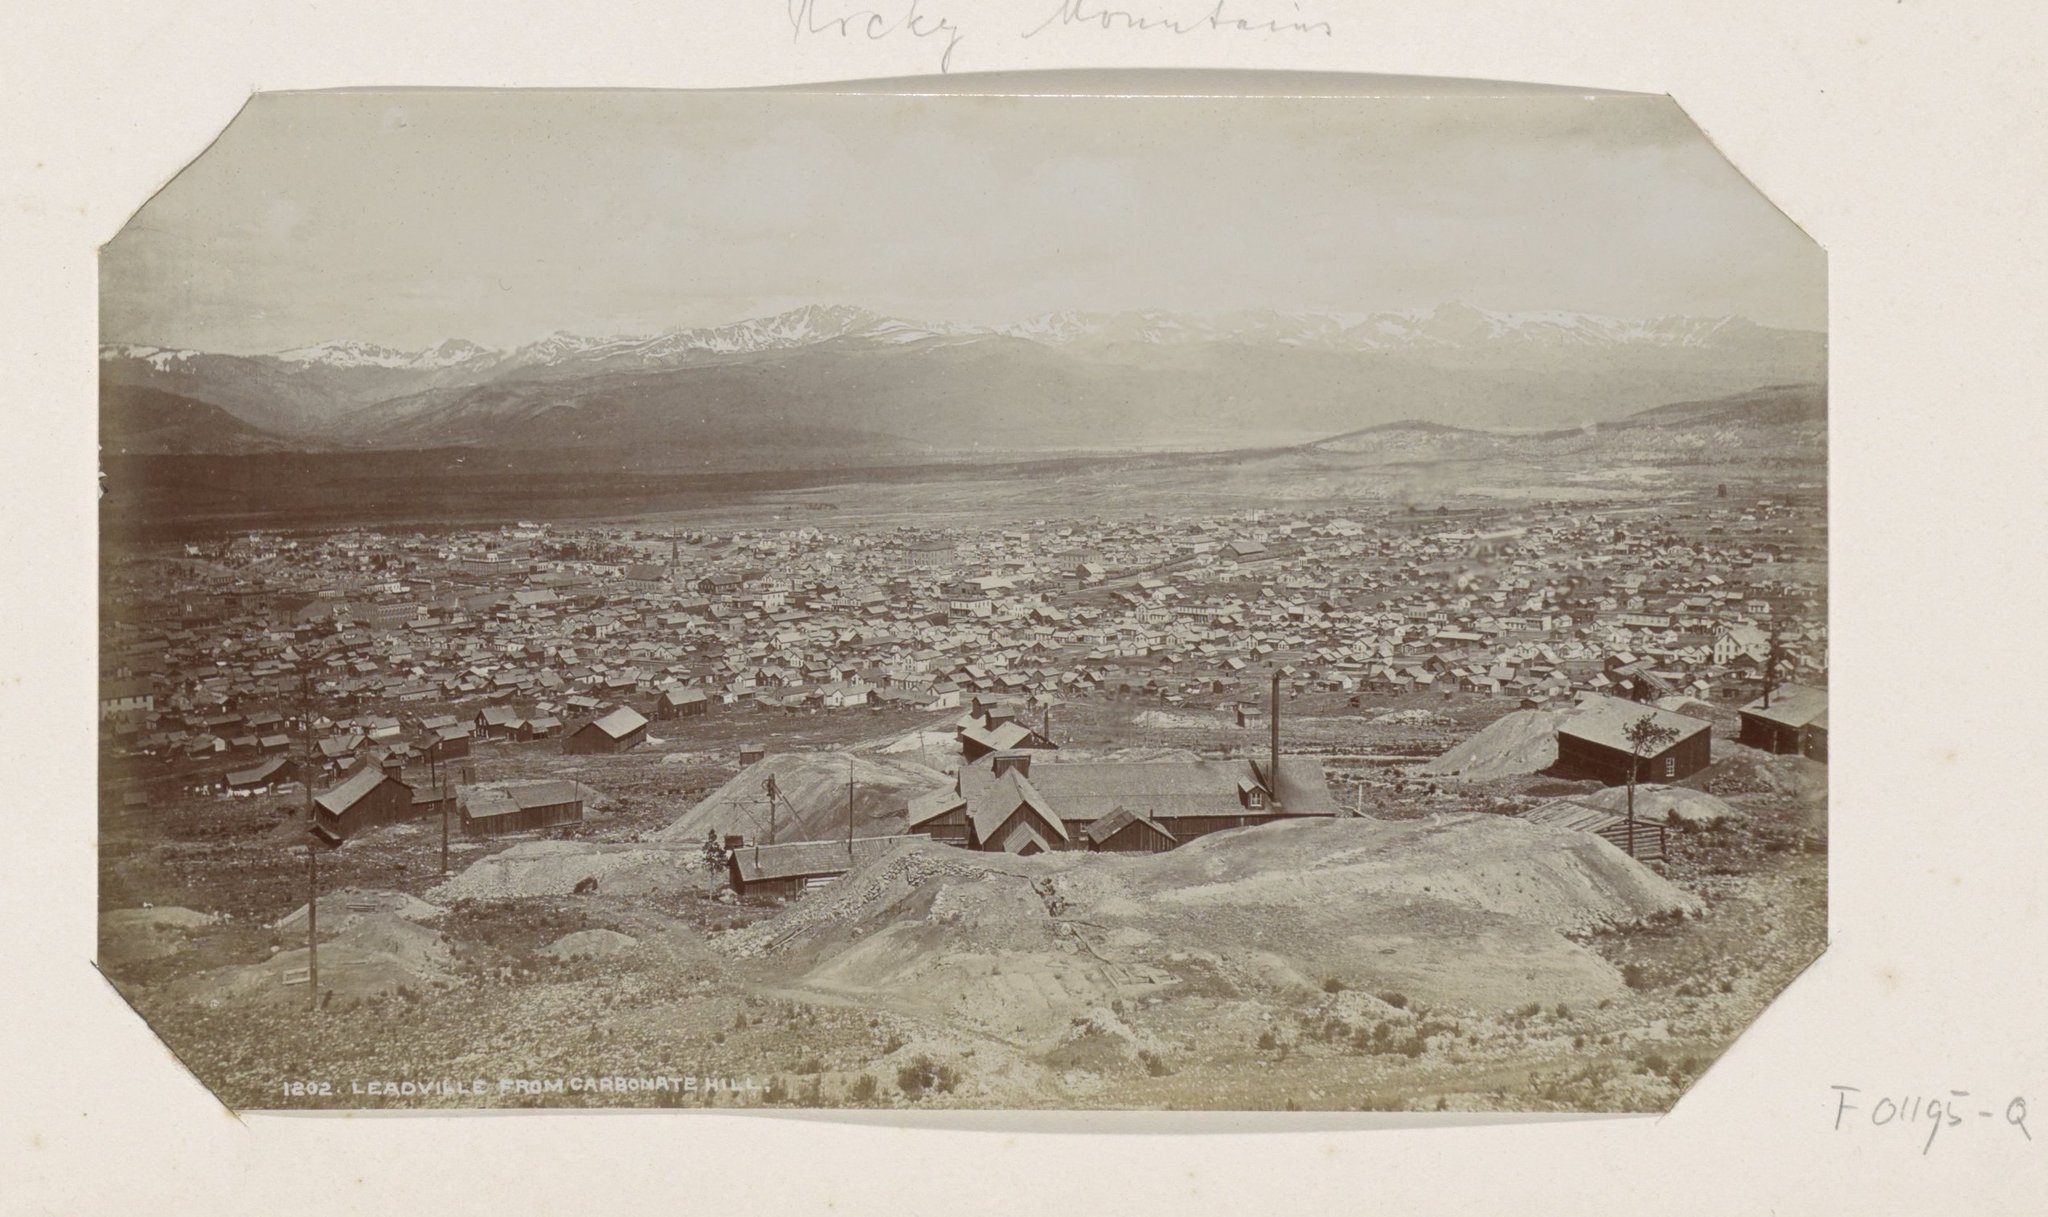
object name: photograph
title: Leadville from Carbonate Hill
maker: william henry jackson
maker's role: fotograaf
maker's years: 1843-1942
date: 1860-1900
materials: cardboard, paper, photographic support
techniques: gelatin silver print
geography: leadville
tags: mining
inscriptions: negative number: ‘1202’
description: Onderdeel van Fotoalbum van een reis door de Verenigde Staten, Honolulu, Nederlands-Indië, Aden, Zanzibar en Zuidelijk Afrika.